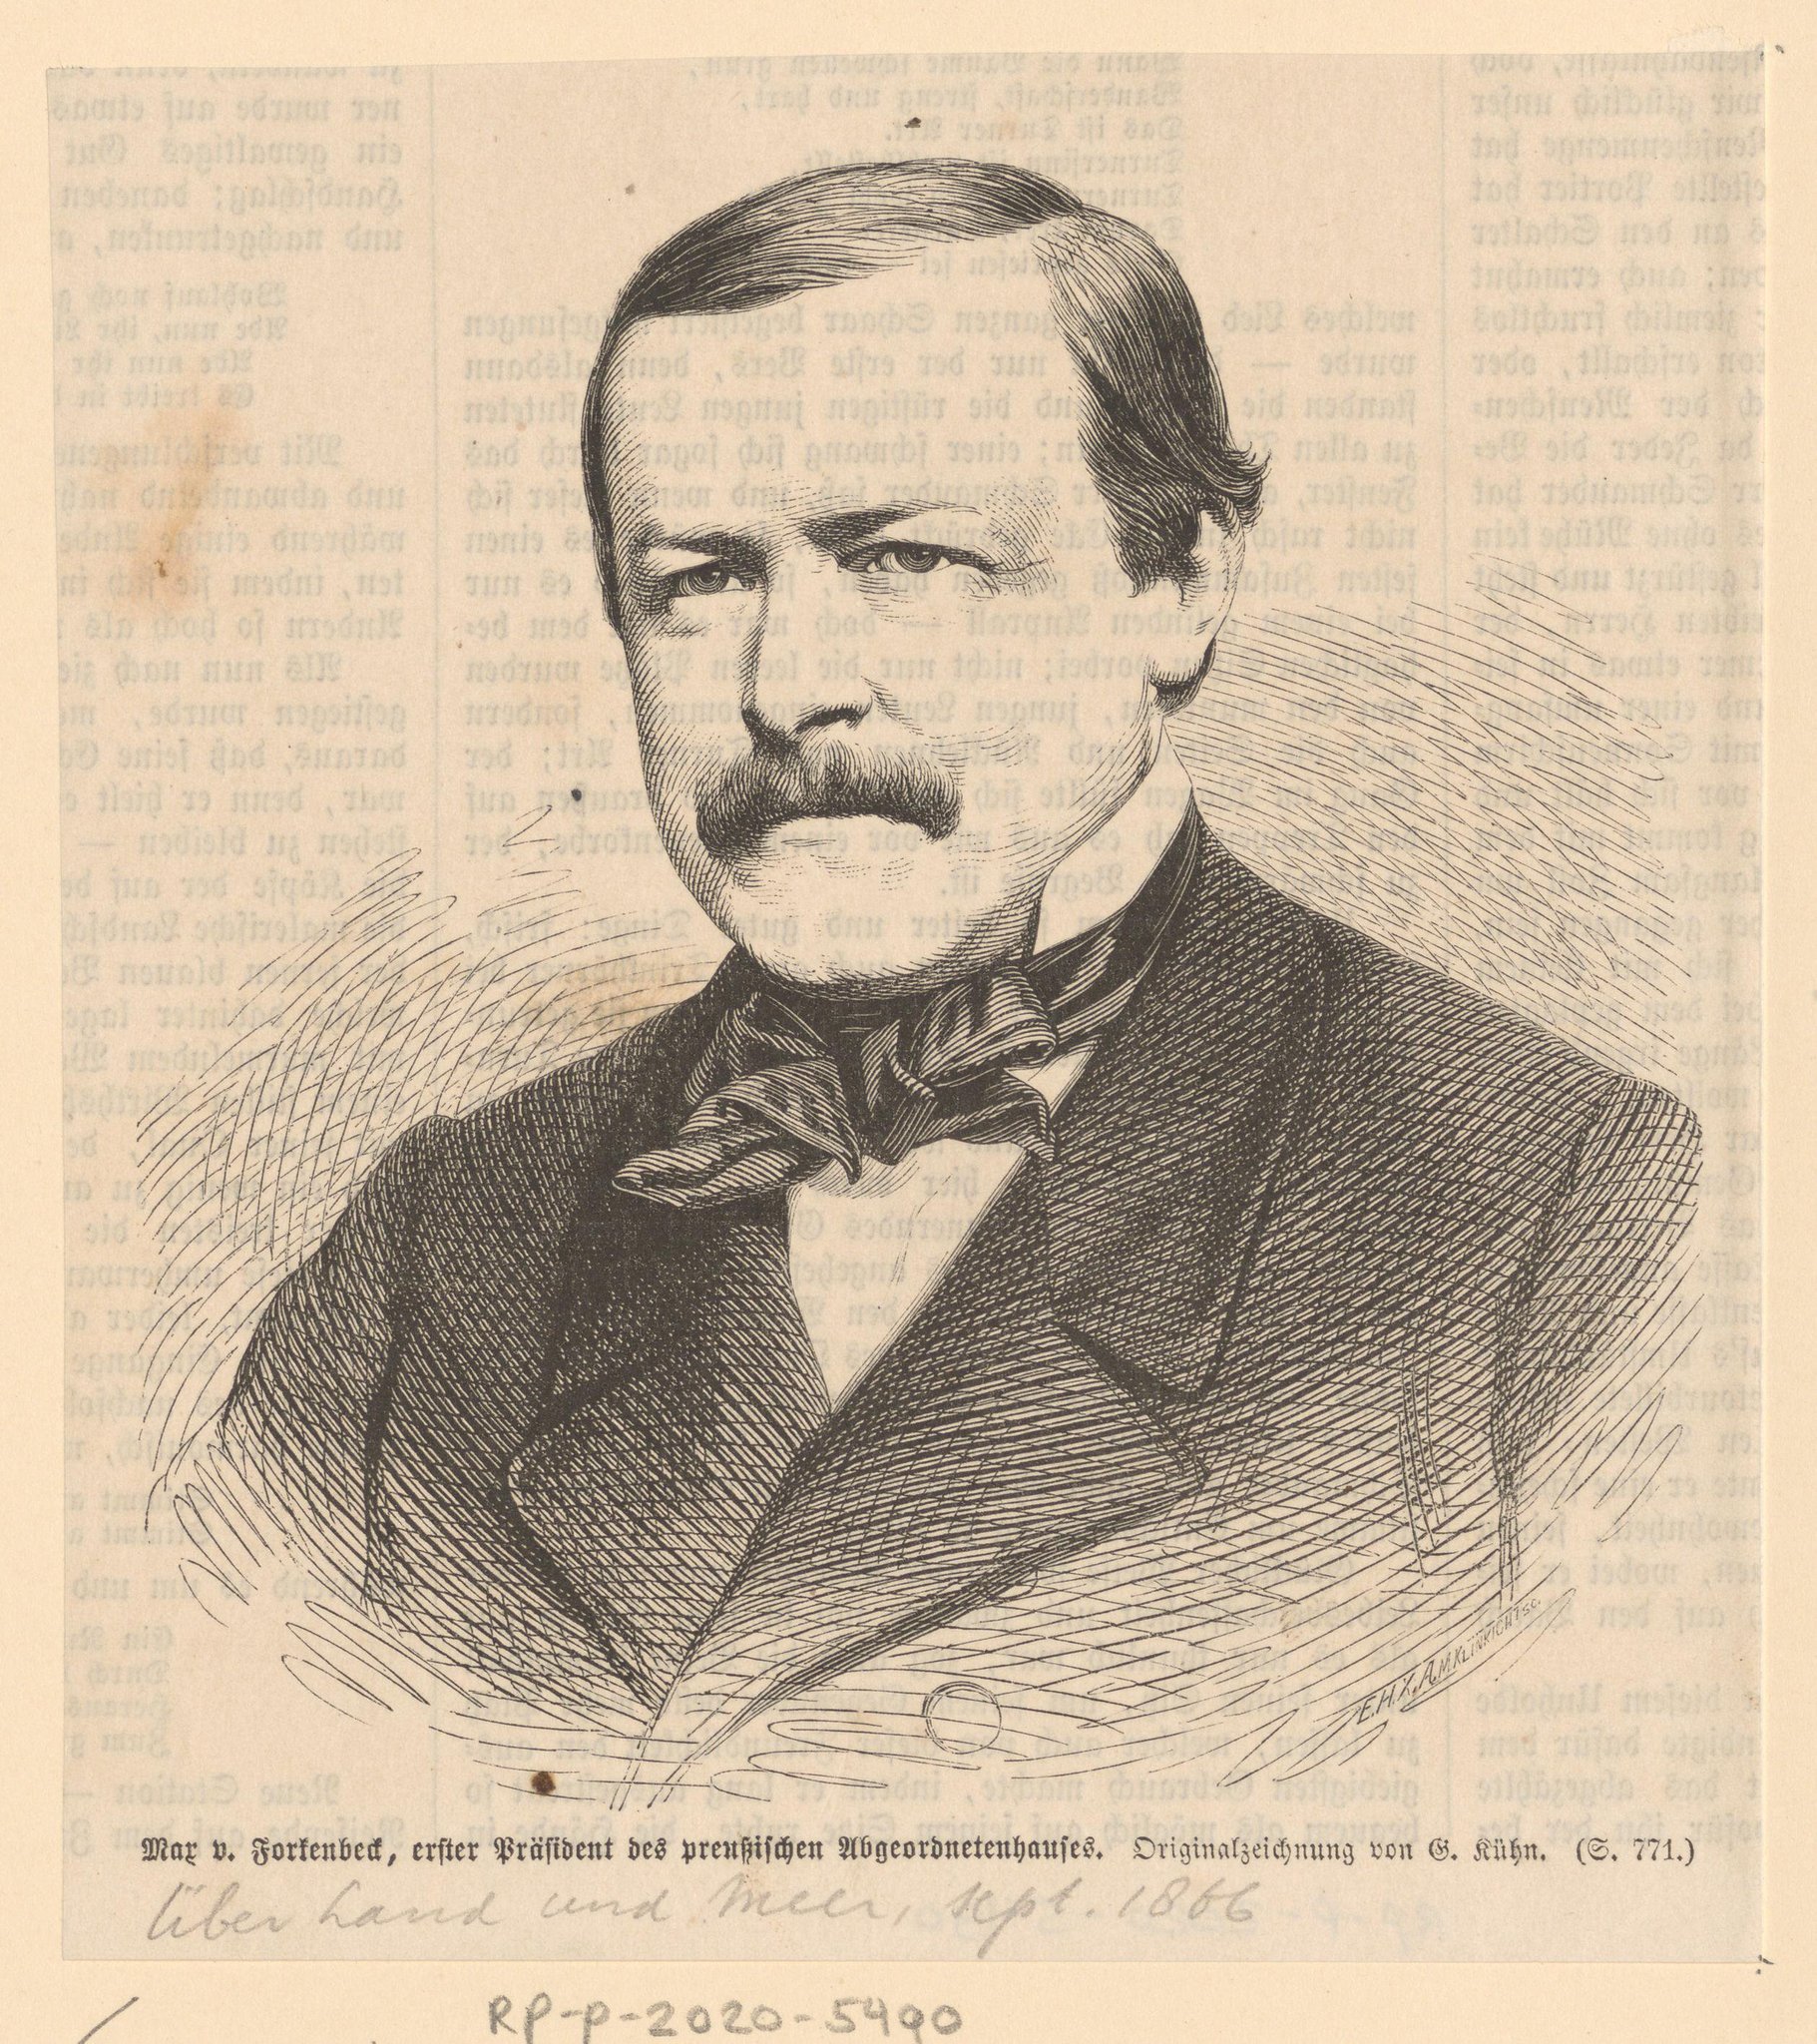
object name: print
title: Portret van Max von Forckenbeck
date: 1866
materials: paper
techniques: letterpress printing, engraving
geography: germany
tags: historical persons, politician, e.g. party leader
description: Prent uit: Über Land und Meer. Allgemeine illustrirte Zeitung, september 1866.